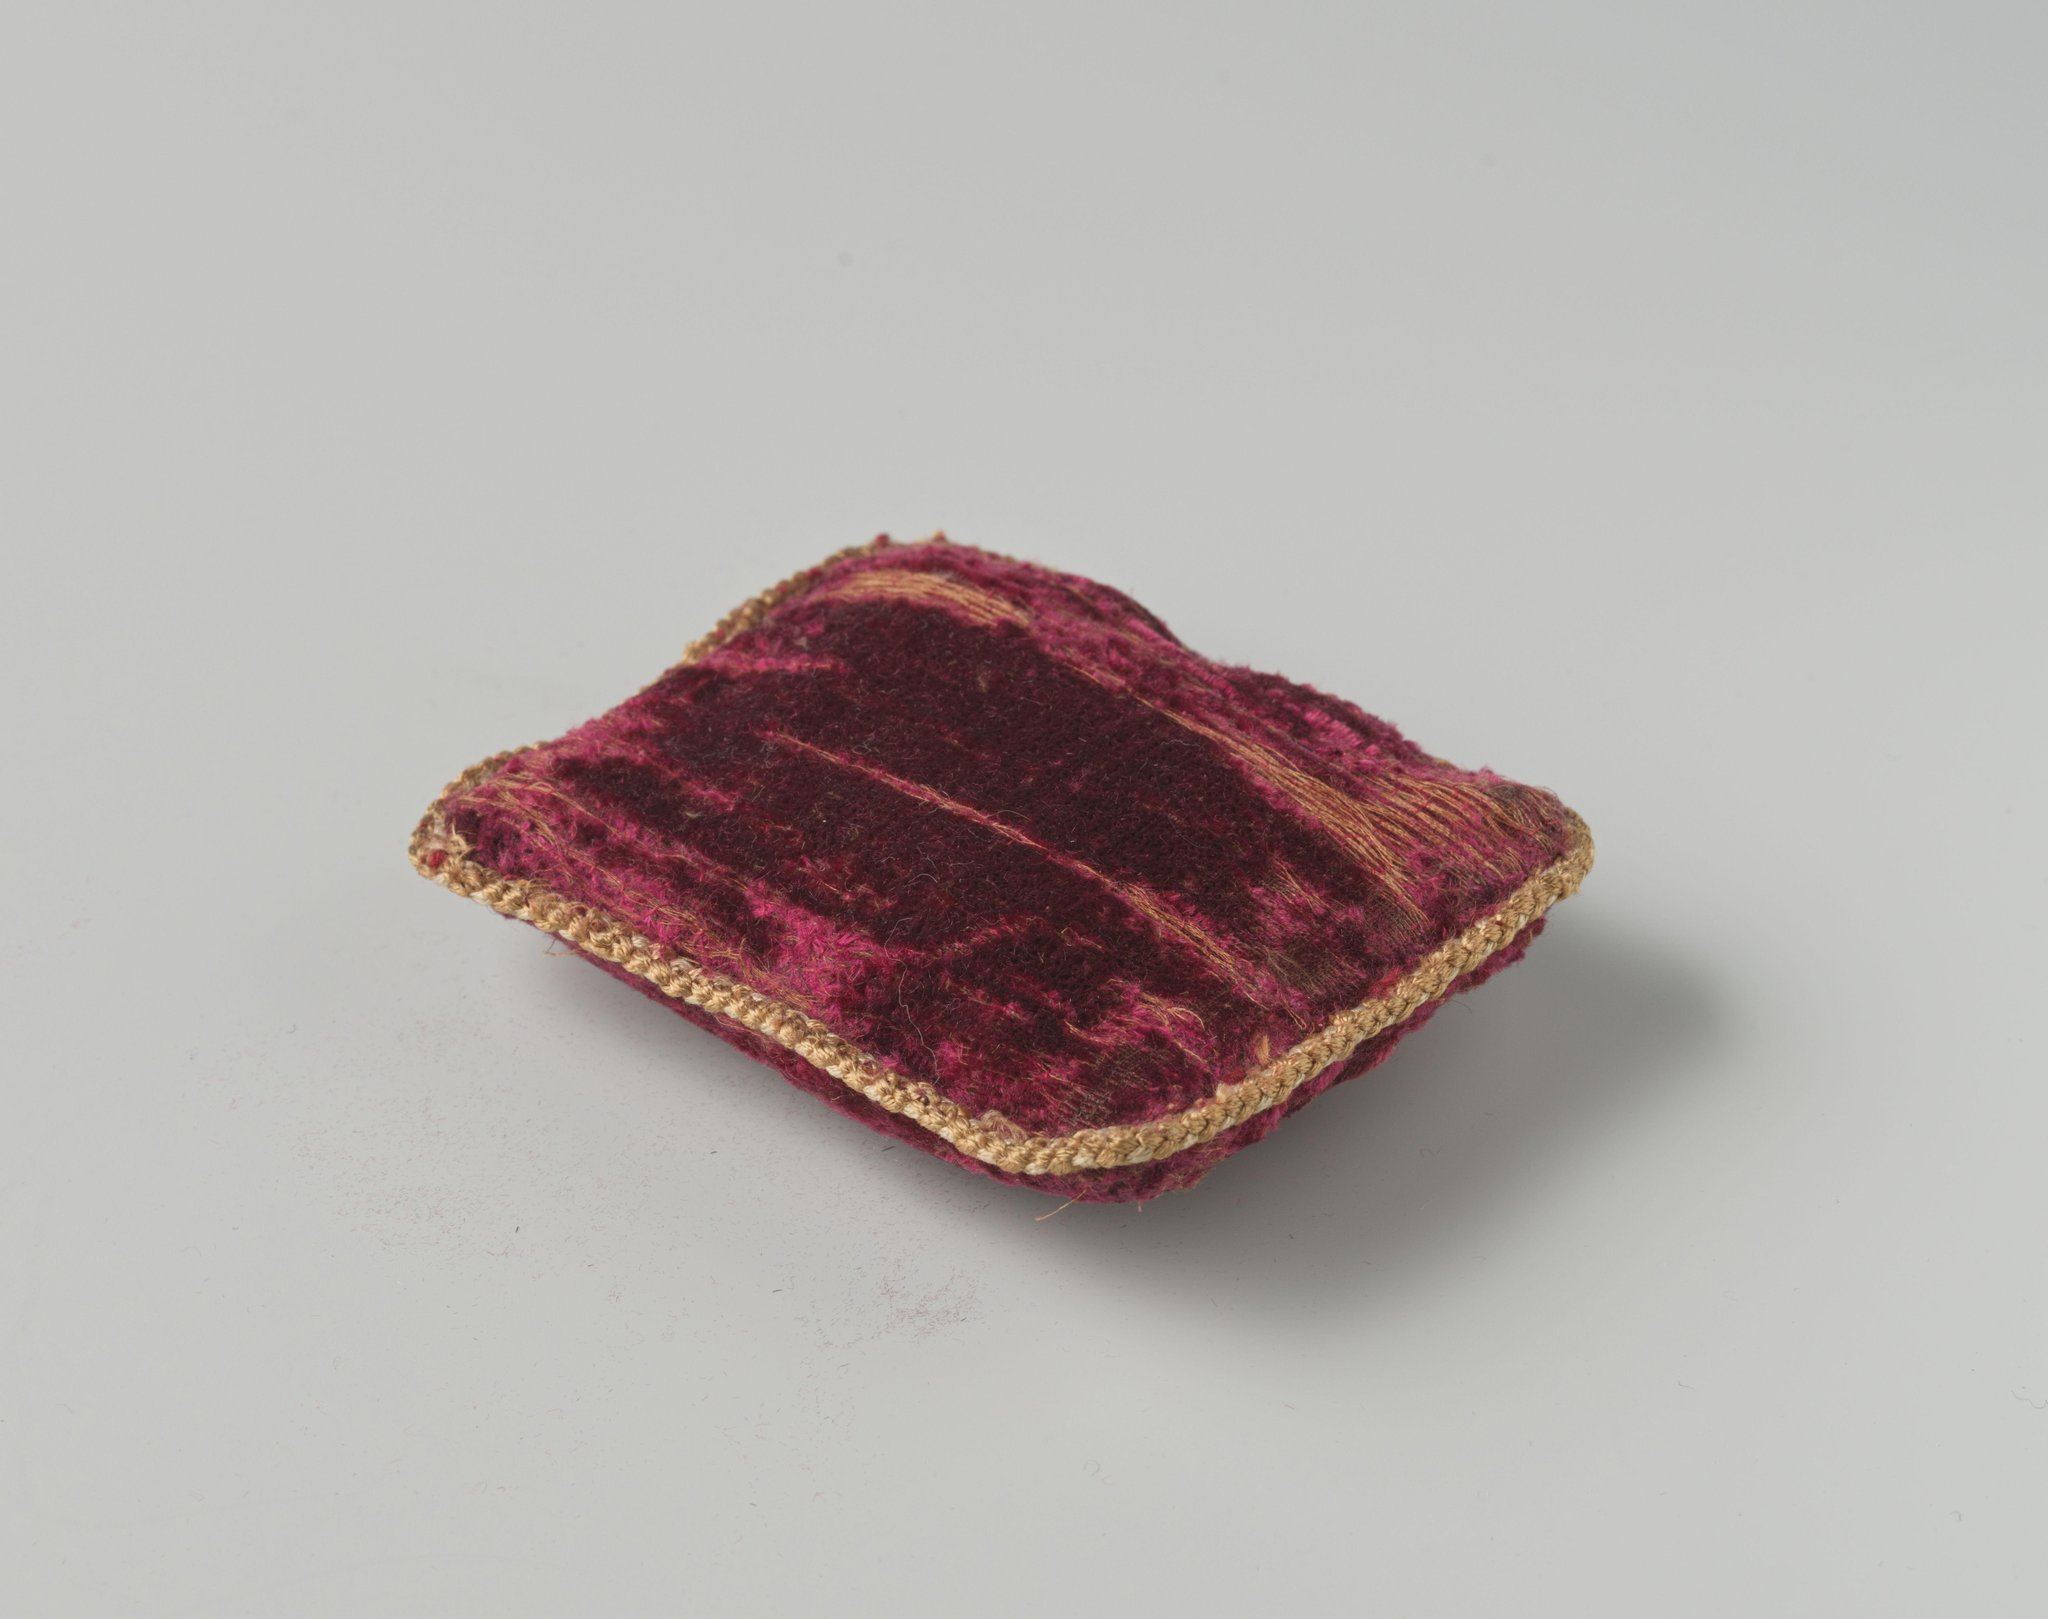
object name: stoelkussen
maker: Anonymous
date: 1690-1710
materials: down, silk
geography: amsterdam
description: Rechthoekige dikke stoelkussen van bordeaux rode zijden fluweel, rondom afgezet met wit / bruin gevlochten koord van zijde. De vulling van dons was oorspronklijk zonder binnenhoes in het kussen gestopt.